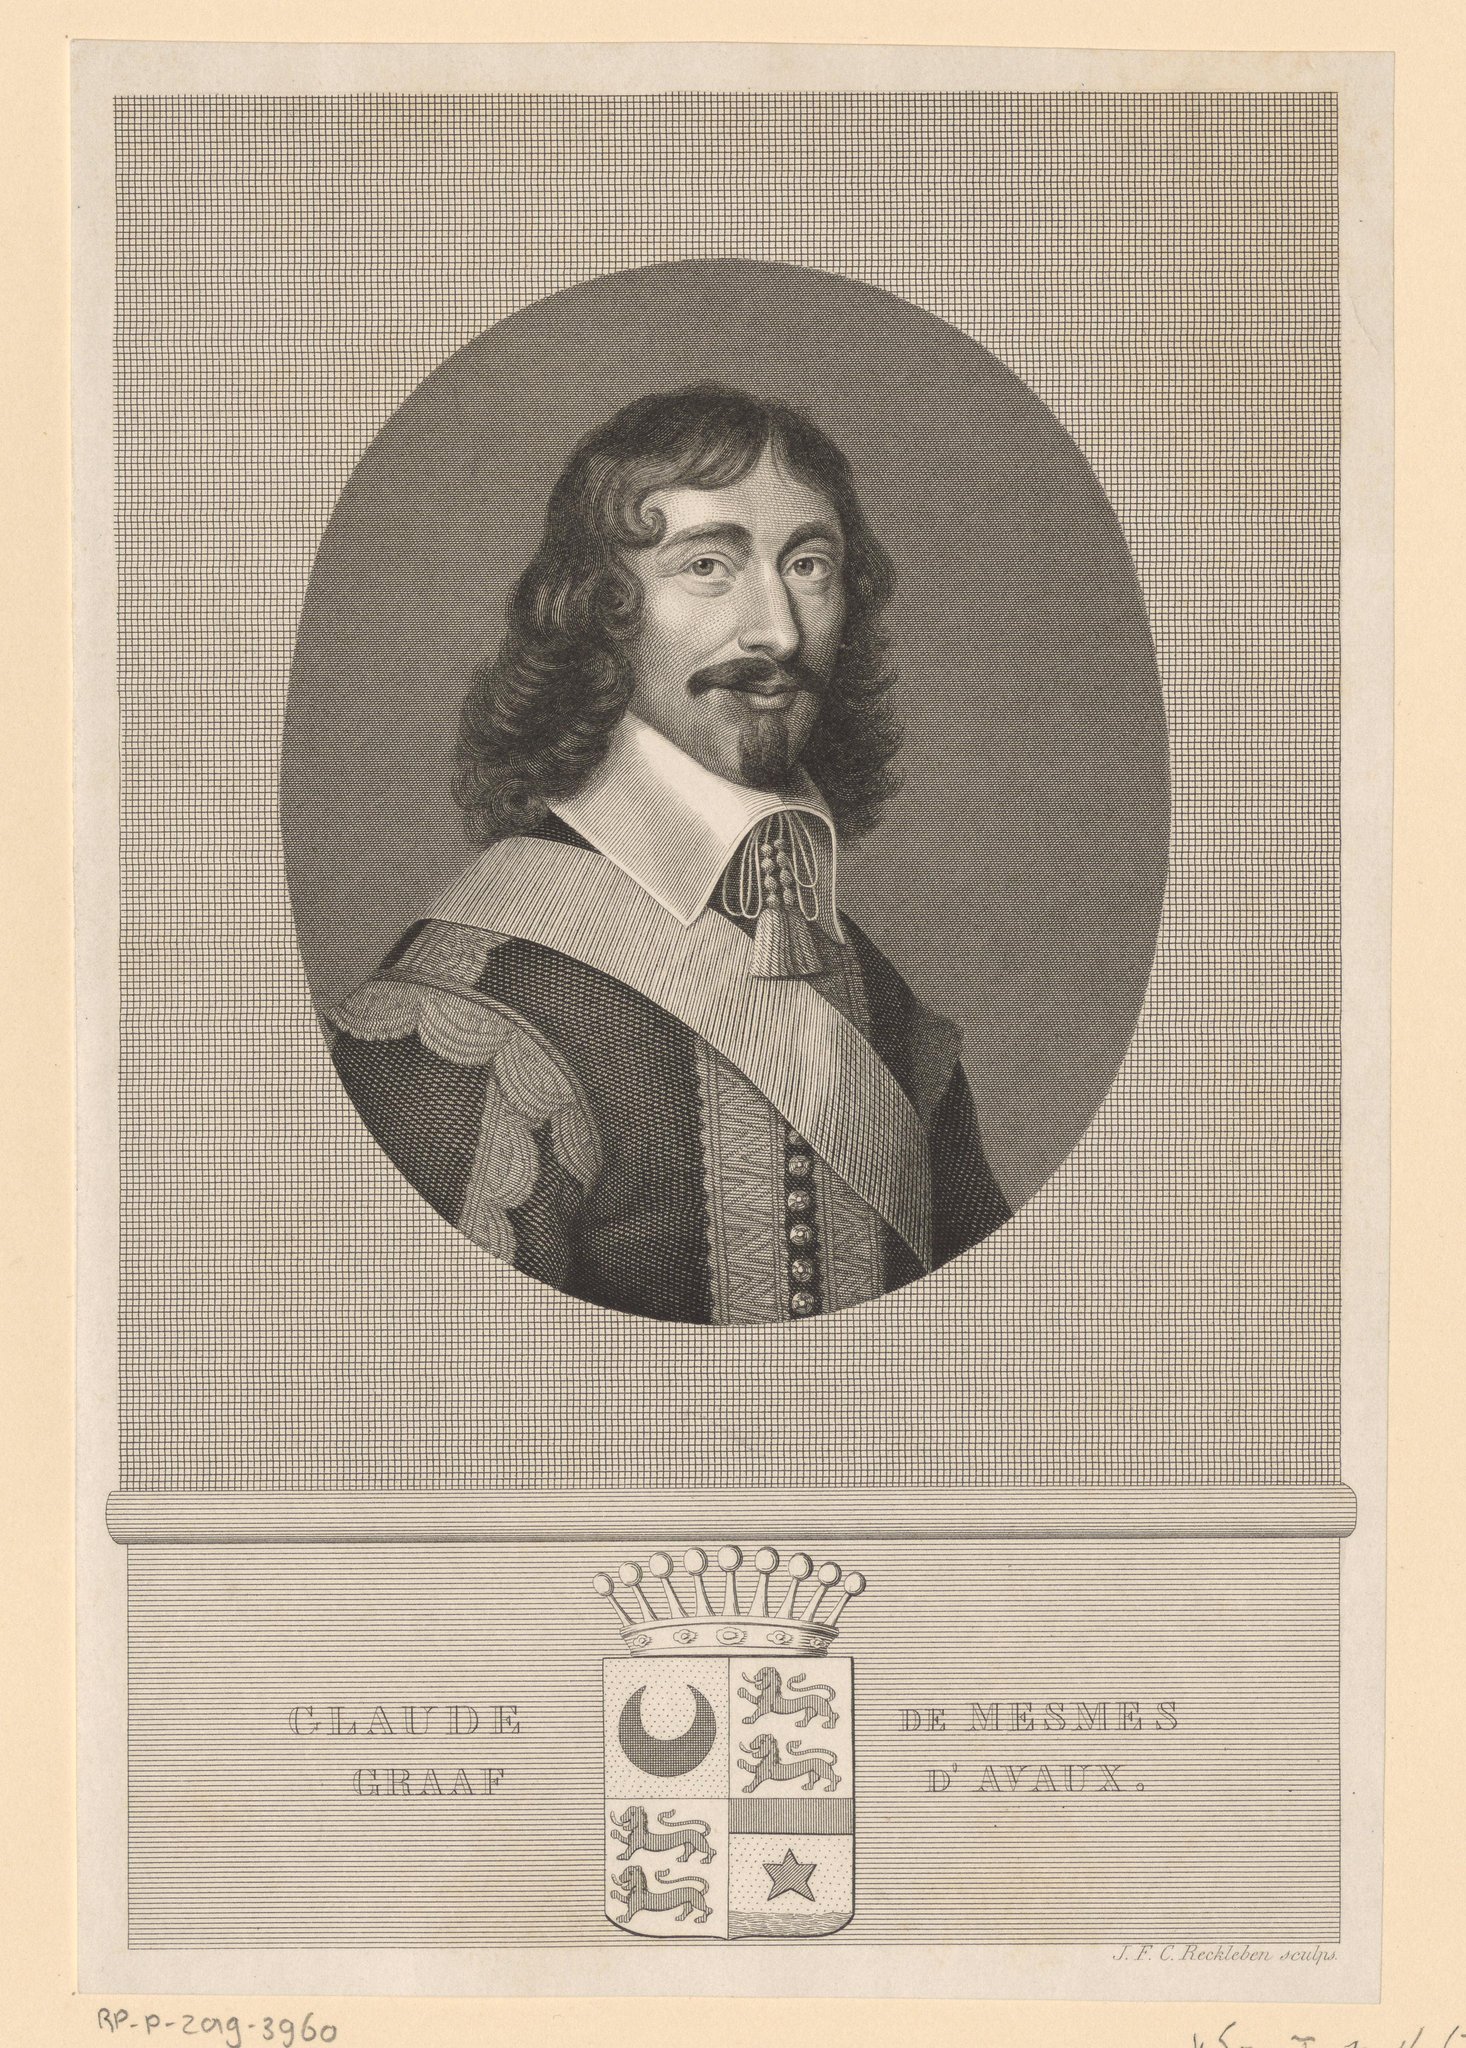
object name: print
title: Portret van Claude de Mesmes, graaf van Avaux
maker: jan frederik christiaan reckleben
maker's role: print maker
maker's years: 1819-1879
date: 1841-1879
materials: paper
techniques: engraving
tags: historical persons, armorial bearing, heraldry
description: Prent uit: Arend, Johannes Pieter. Algemeene geschiedenis des vaderlands van de vroegste tijden tot op heden. Amsterdam, Leiden en Haarlem: s.n., 1841-1879, dl. 3.